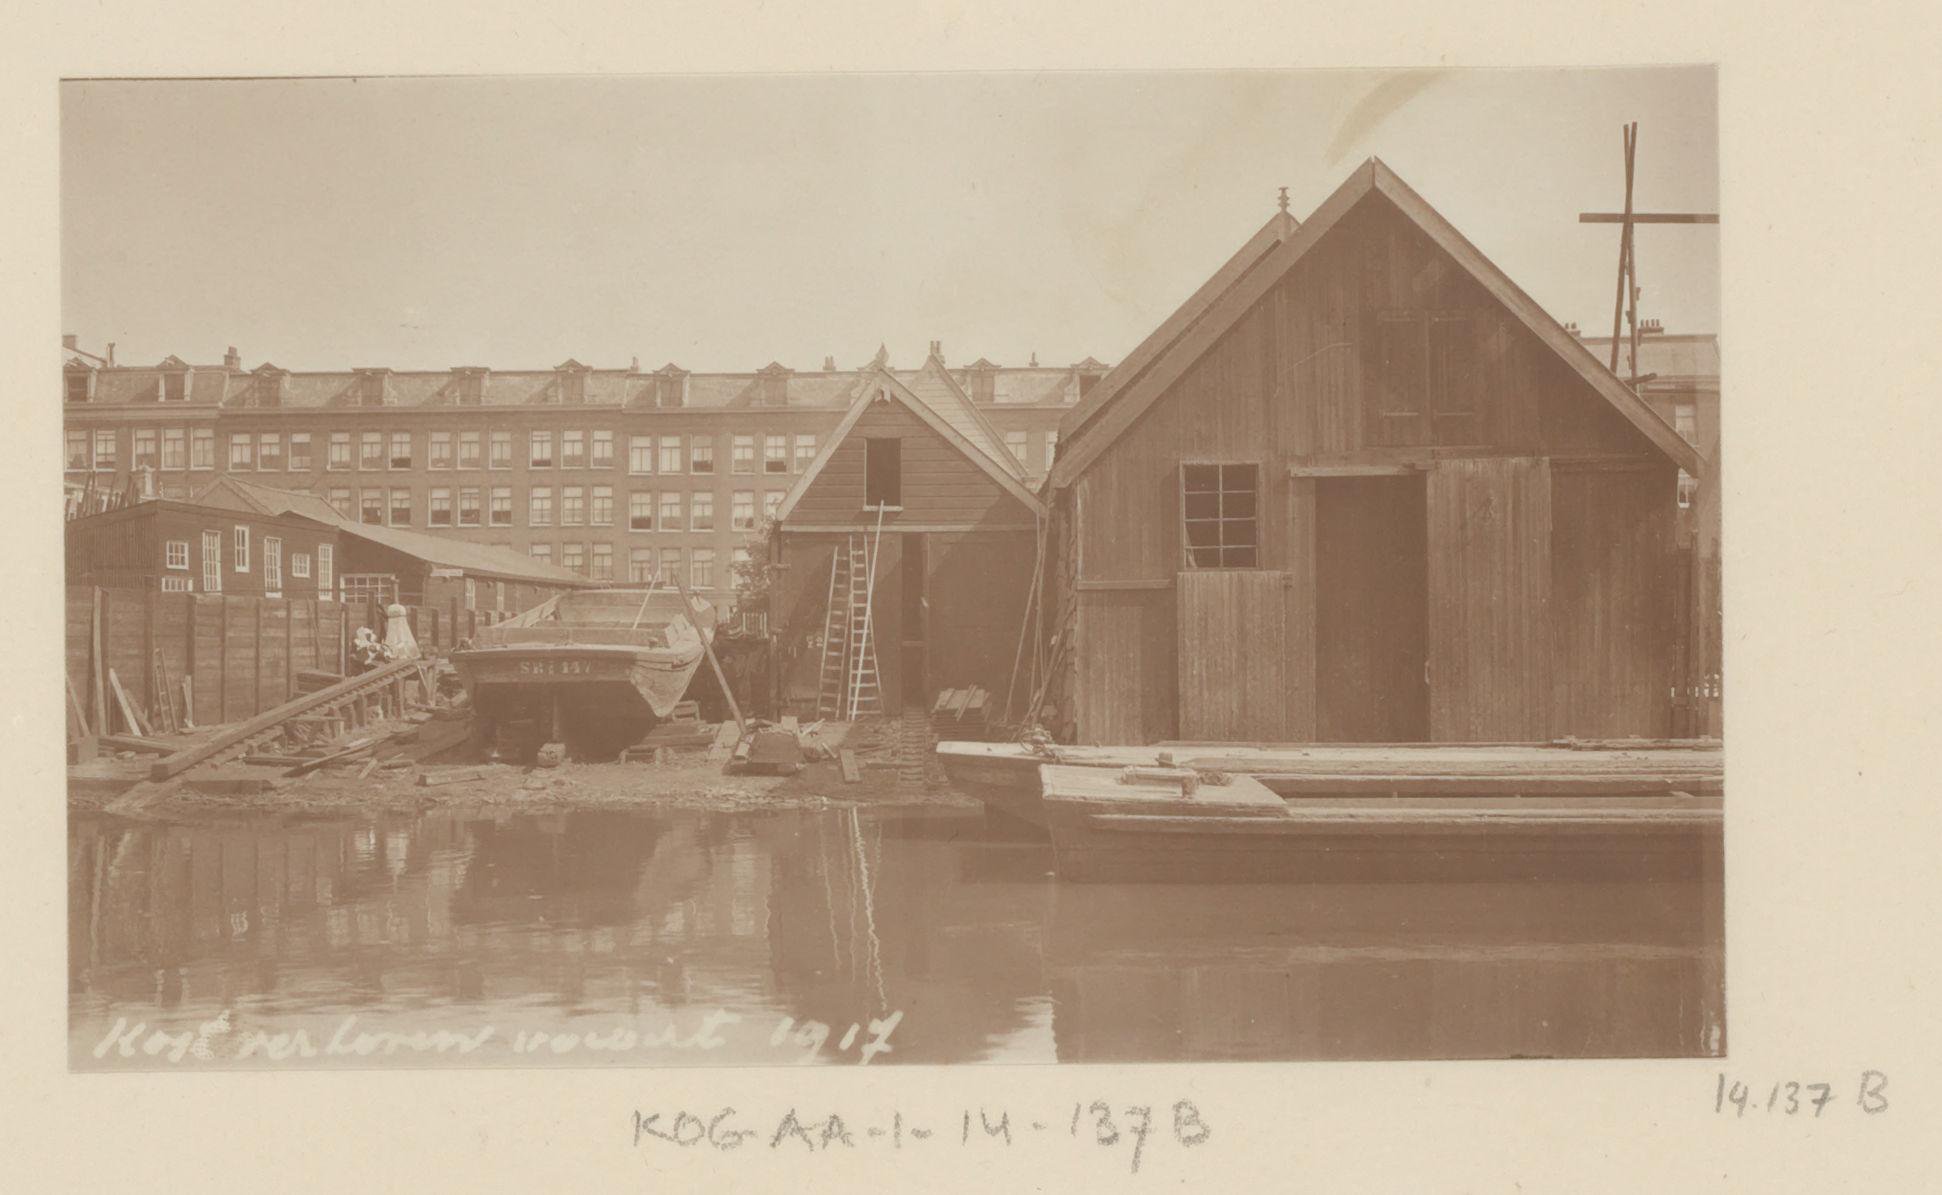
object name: photograph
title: Gezicht op de Kostverlorenvaart bij de De Wittenkade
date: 1917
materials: cardboard, paper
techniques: albumen print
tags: city-view in general; 'veduta', canal, tow-boat, towing-barge, shed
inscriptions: collector's mark: ‘14 137AB’ Lugt 1641b, inscription: ‘Kostverlorenvaart. (de Wittenkade) / in 1917. / April 1920. / Geschenk v/d Heer J. van Eck.’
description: Onderwerpsrubriek binnen de Atlas Amsterdam: Waal (Kromme en Oude), Walenpleintje, Warmoesgracht, Warmoesstraat, Waterlooplein, Westerdoksdijk, Westermarkt, Weteringschans, Willemspark, Willemsstraat, Wittenburg, Wittenkade (de), Wittenstraat (de).